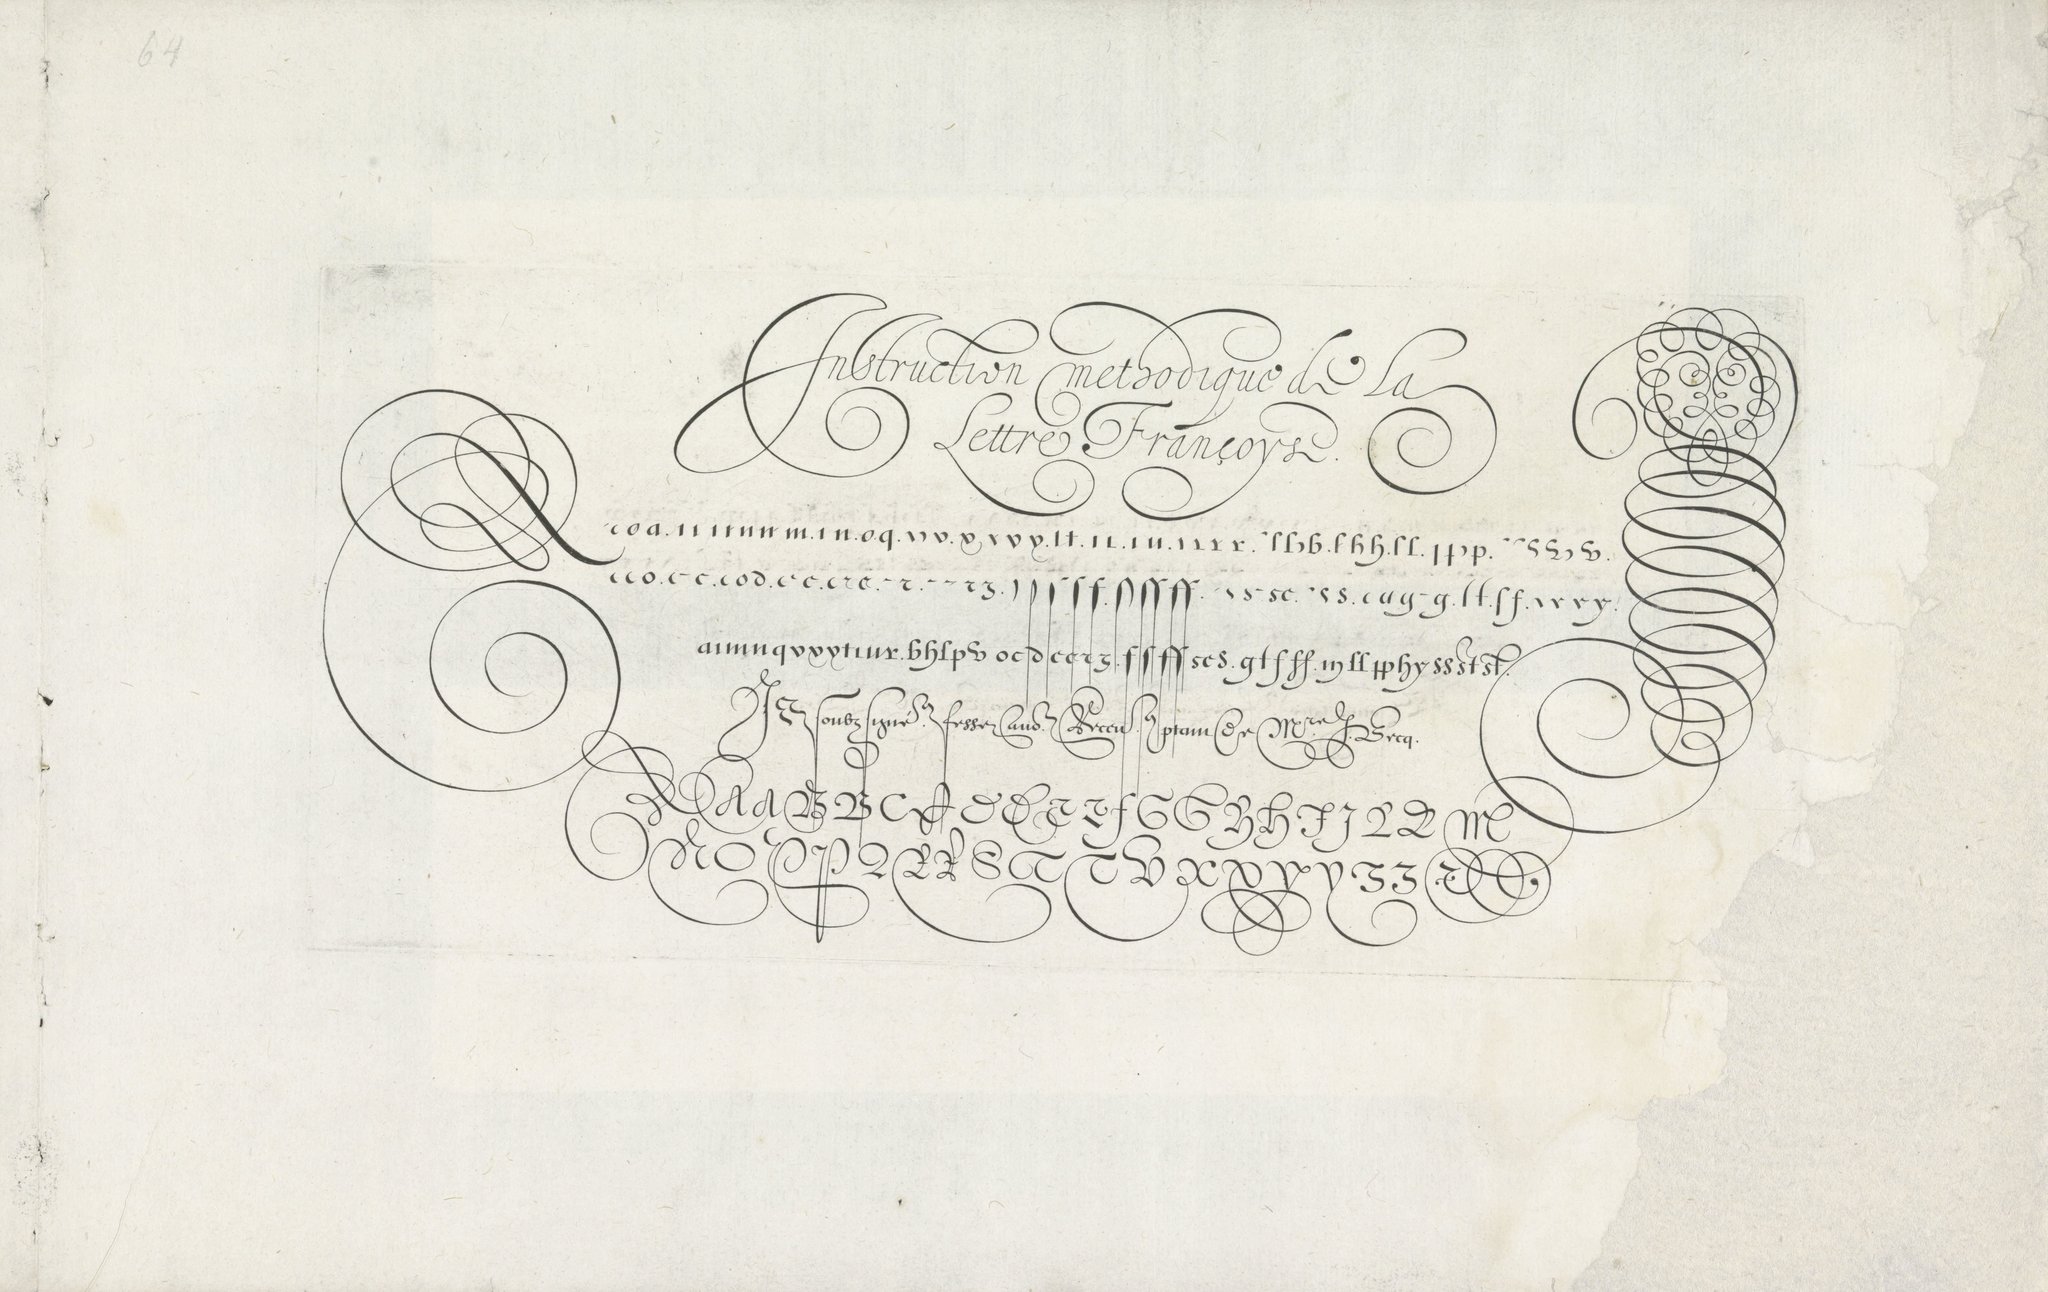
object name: ornament print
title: Schrijfvoorbeeld: de Franse letter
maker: simon frisius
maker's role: print maker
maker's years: 1570-1628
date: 1605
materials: paper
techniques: engraving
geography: rotterdam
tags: calligraphy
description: Schrijfvoorbeeld bestaande uit vijf regels letters en tekst in de Franse letter. Daarboven de aanhef: Instructien methodique ... Met krulwerk. De prent maakt deel uit van een album.